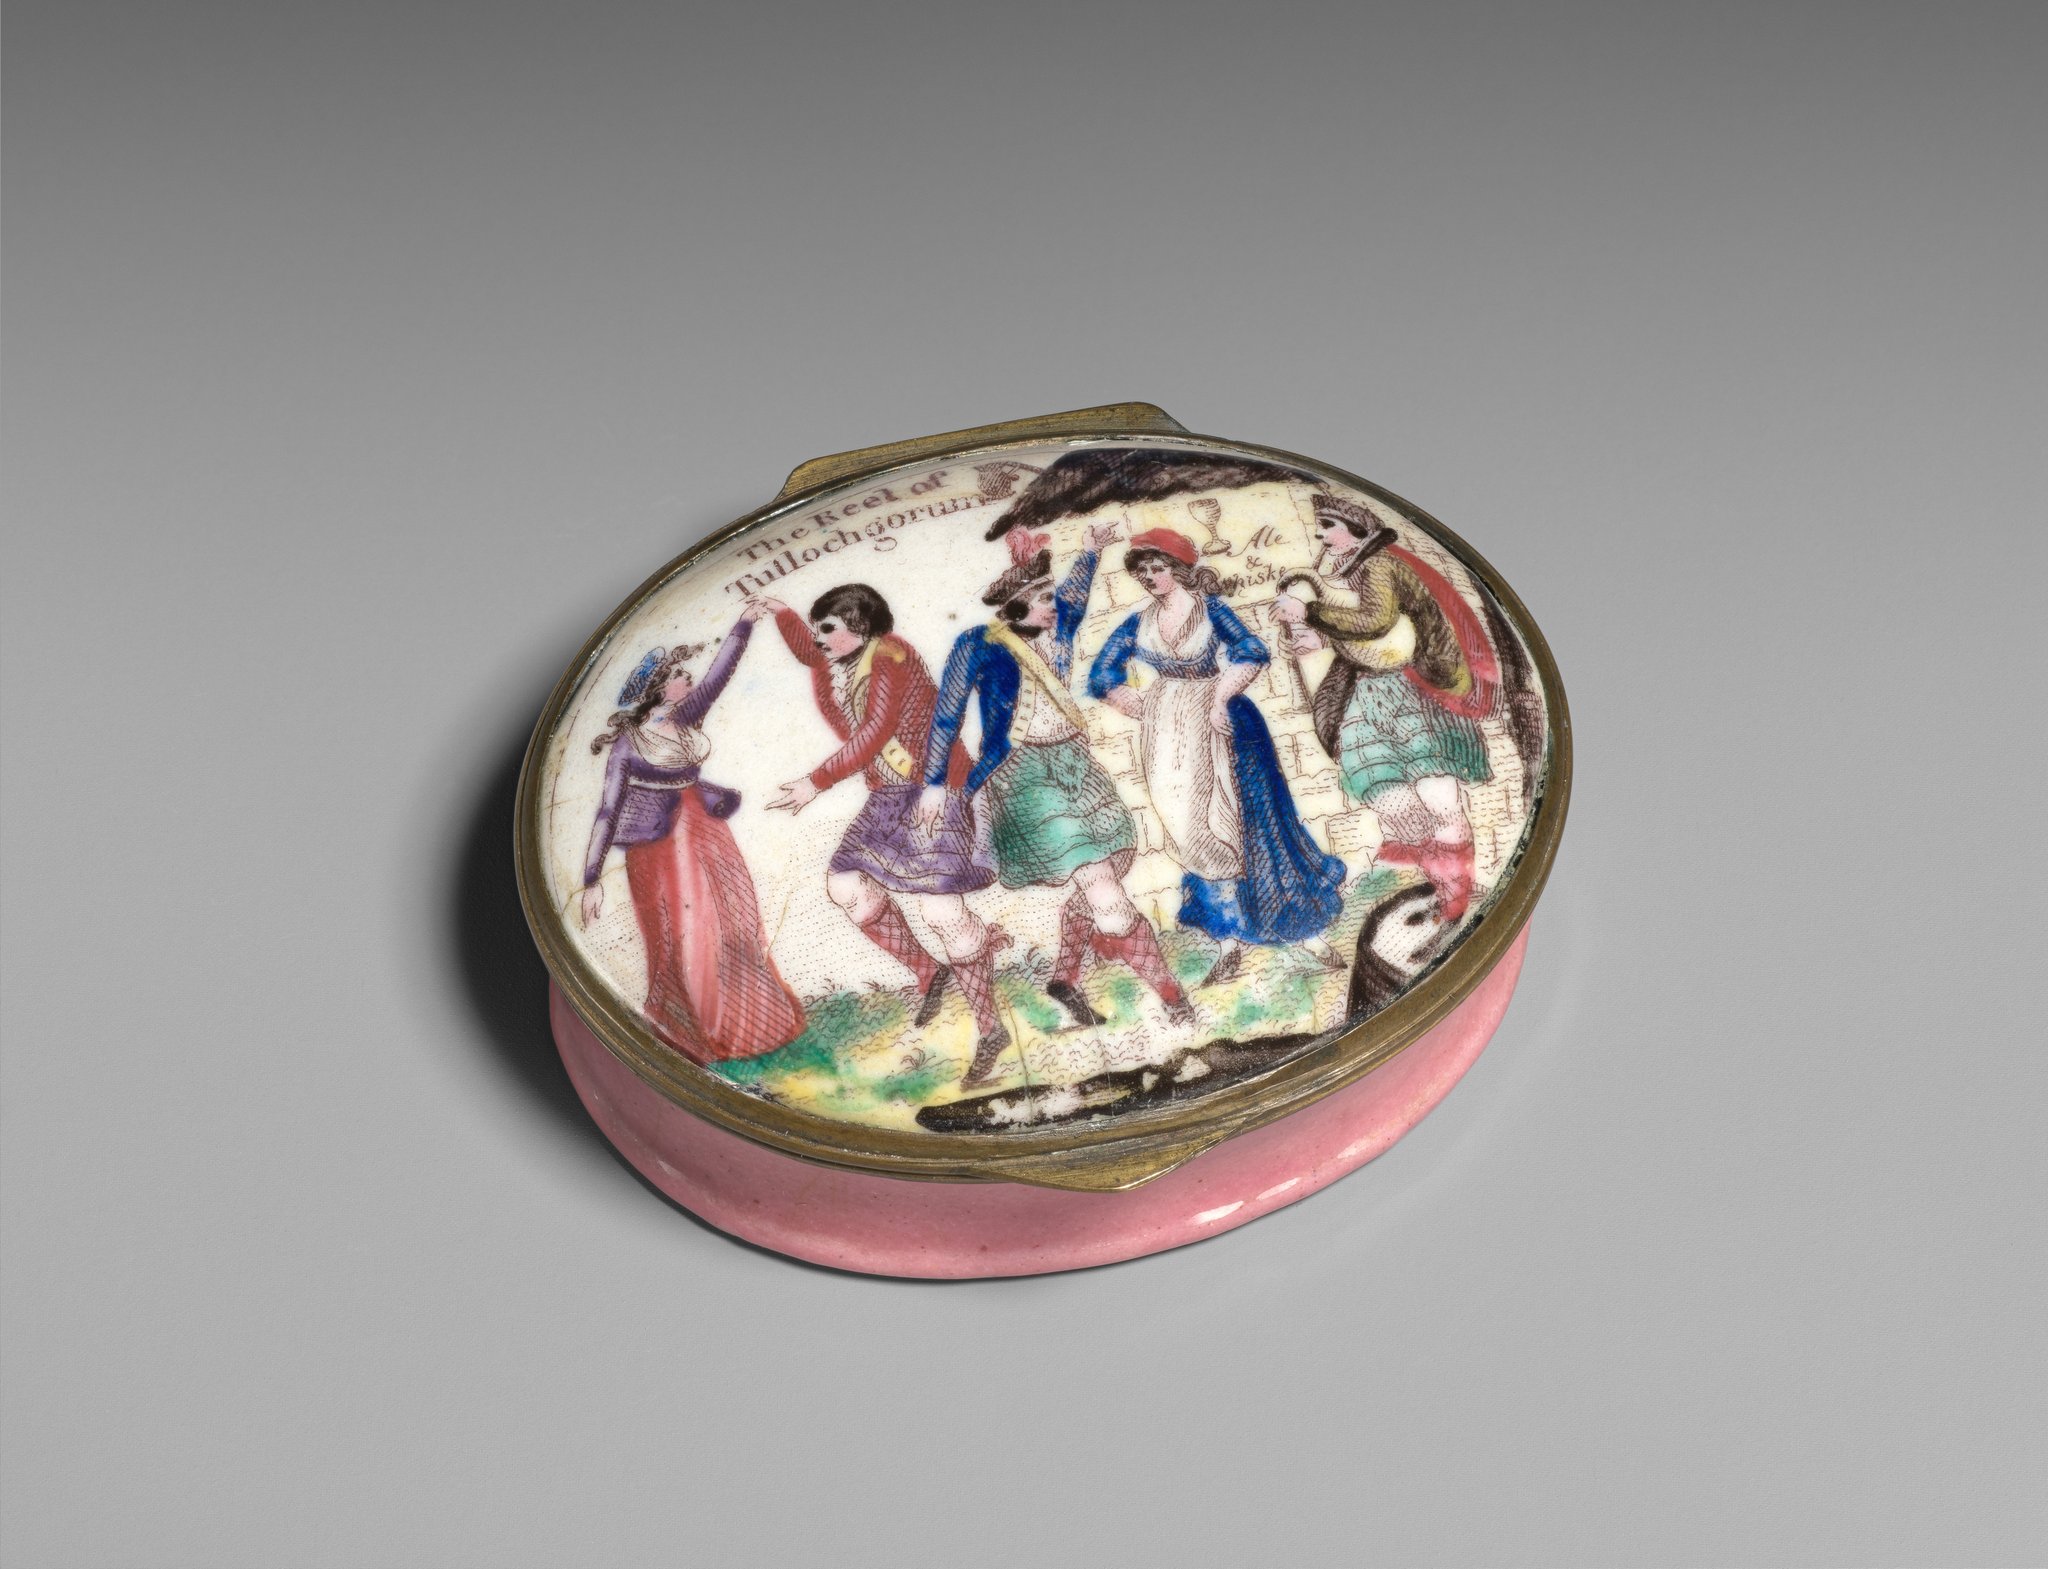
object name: patch box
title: Patch box with Scottish dancers, “The Reel of Tullochgorum”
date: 1780-1790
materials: copper, enamel, glass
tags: dancing,bagpipes